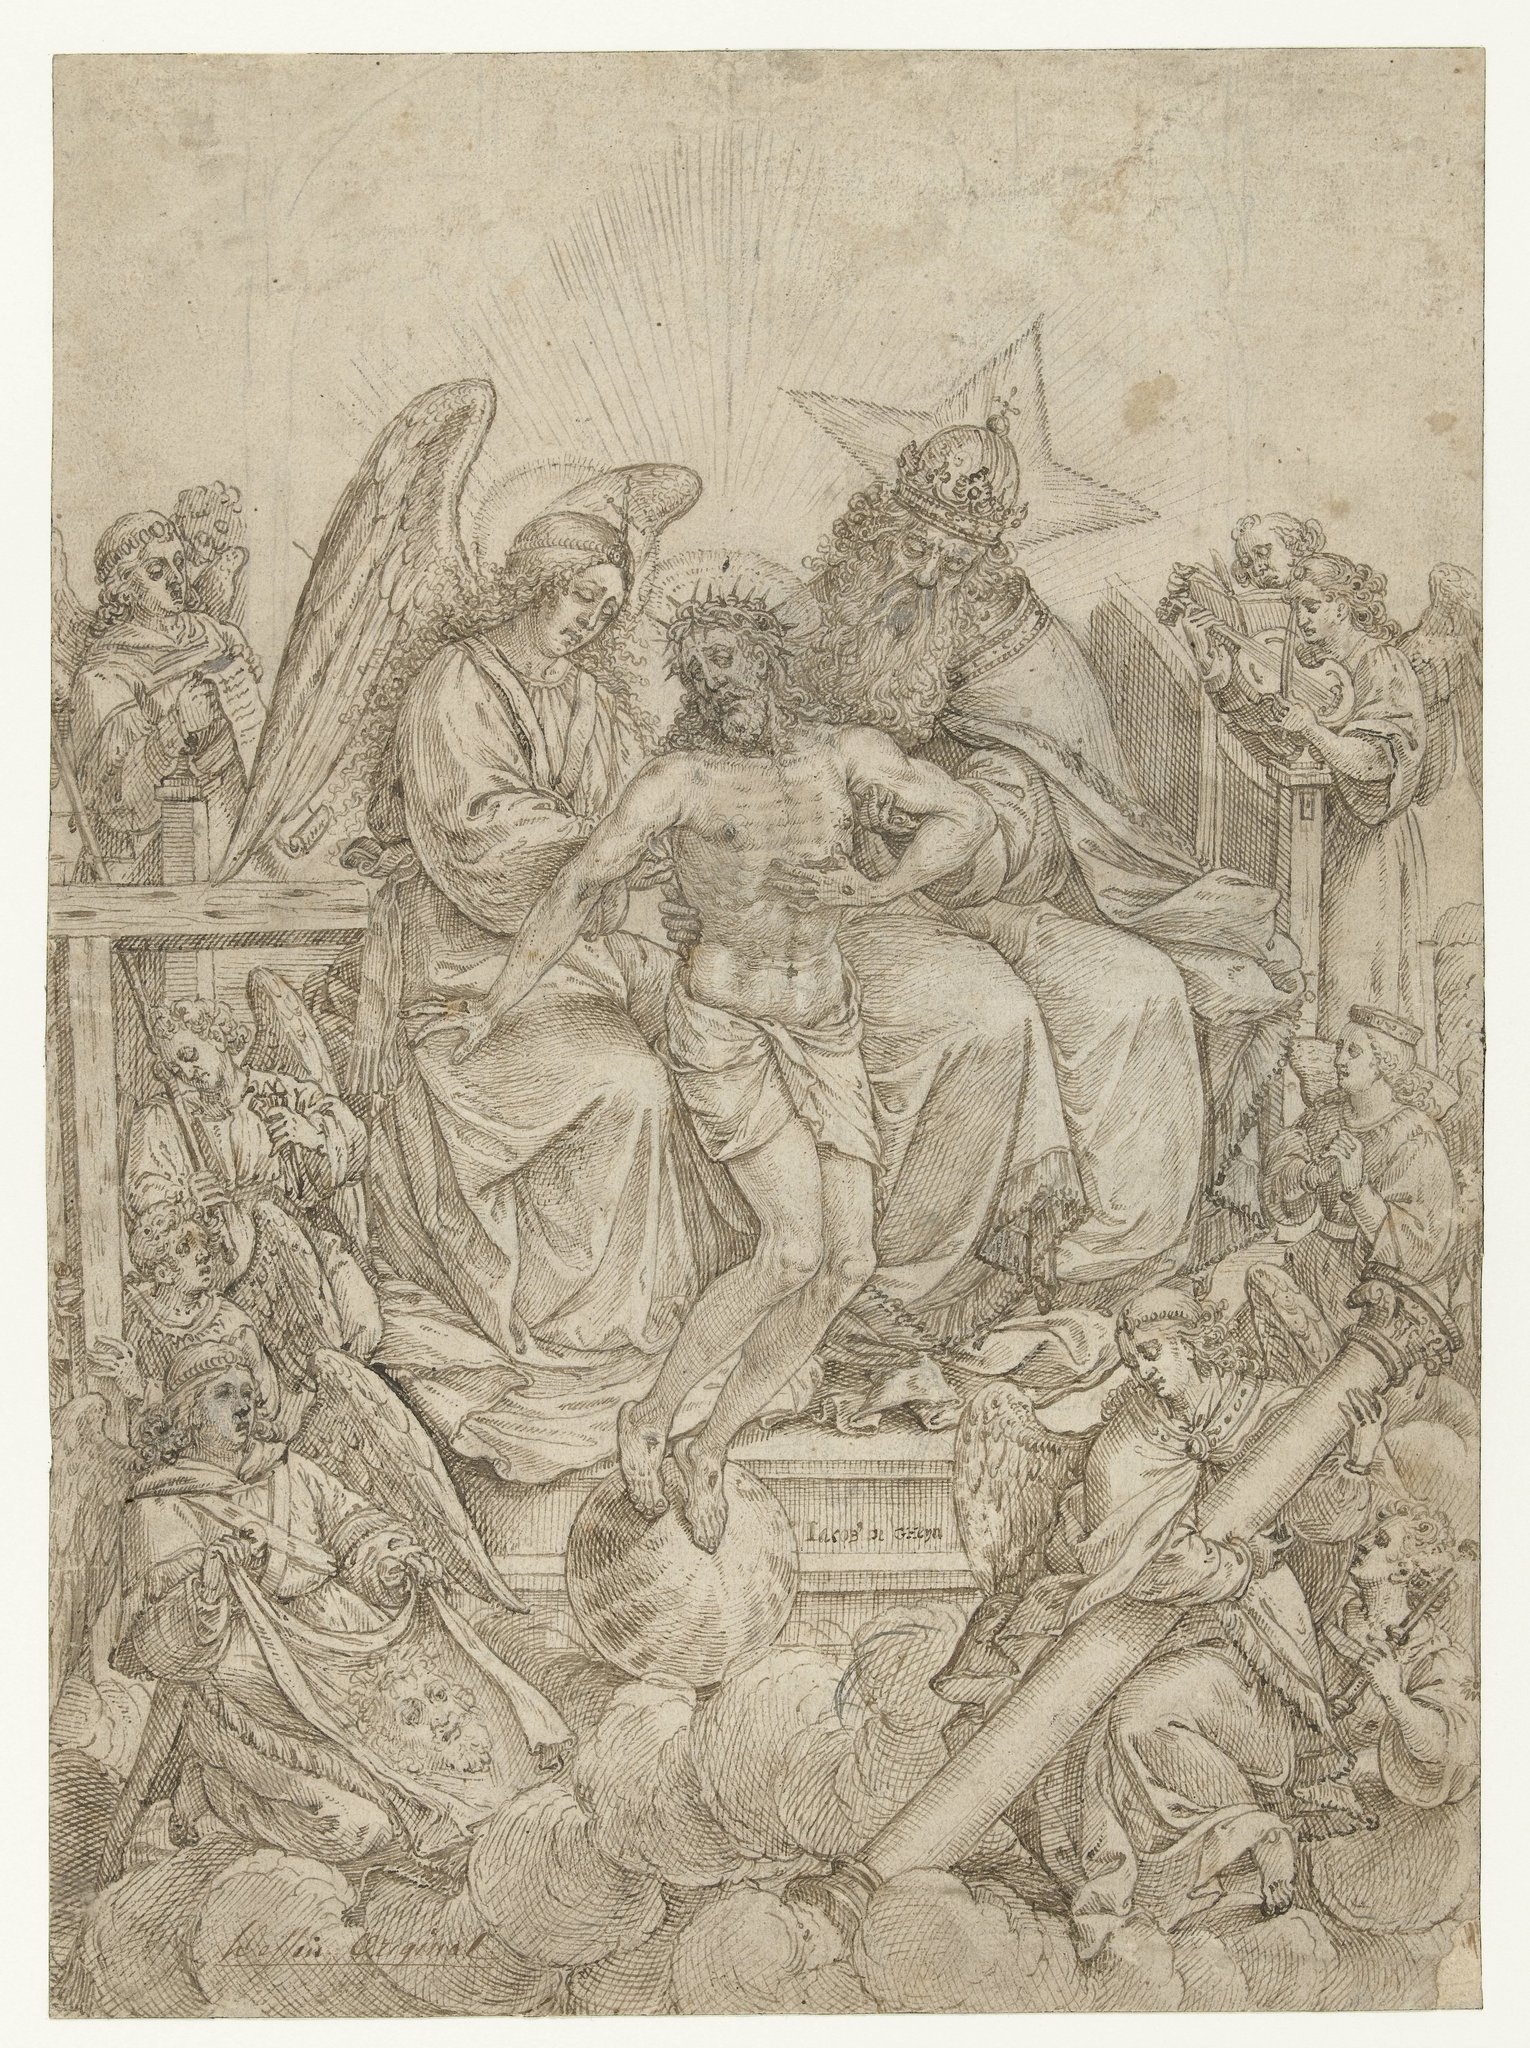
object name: design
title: Genadestoel omringd door engelen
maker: jacques de gheyn (i)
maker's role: draughtsman, print maker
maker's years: 1537-1581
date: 1578-1583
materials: chalk, ink, paint, paper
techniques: pen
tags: god the father holding the crucifix, 'gnadenstuhl', mercy-seat, throne of grace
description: Op de troon God, de Heilige Geest (als een engel) en Christus als de Man van Smarten, met zijn voeten op de aardbol. Links en rechts van de troon, waarvan het bovenste gedeelte alleen de contouren in krijt zijn aangegegen, musicerende engelen. Op de treden voor de troon, knielen engelen op wolken, terwijl ze de instrumenten van Passie vast houden. Mogelijk een ontwerp voor een prent of borduurwerk.